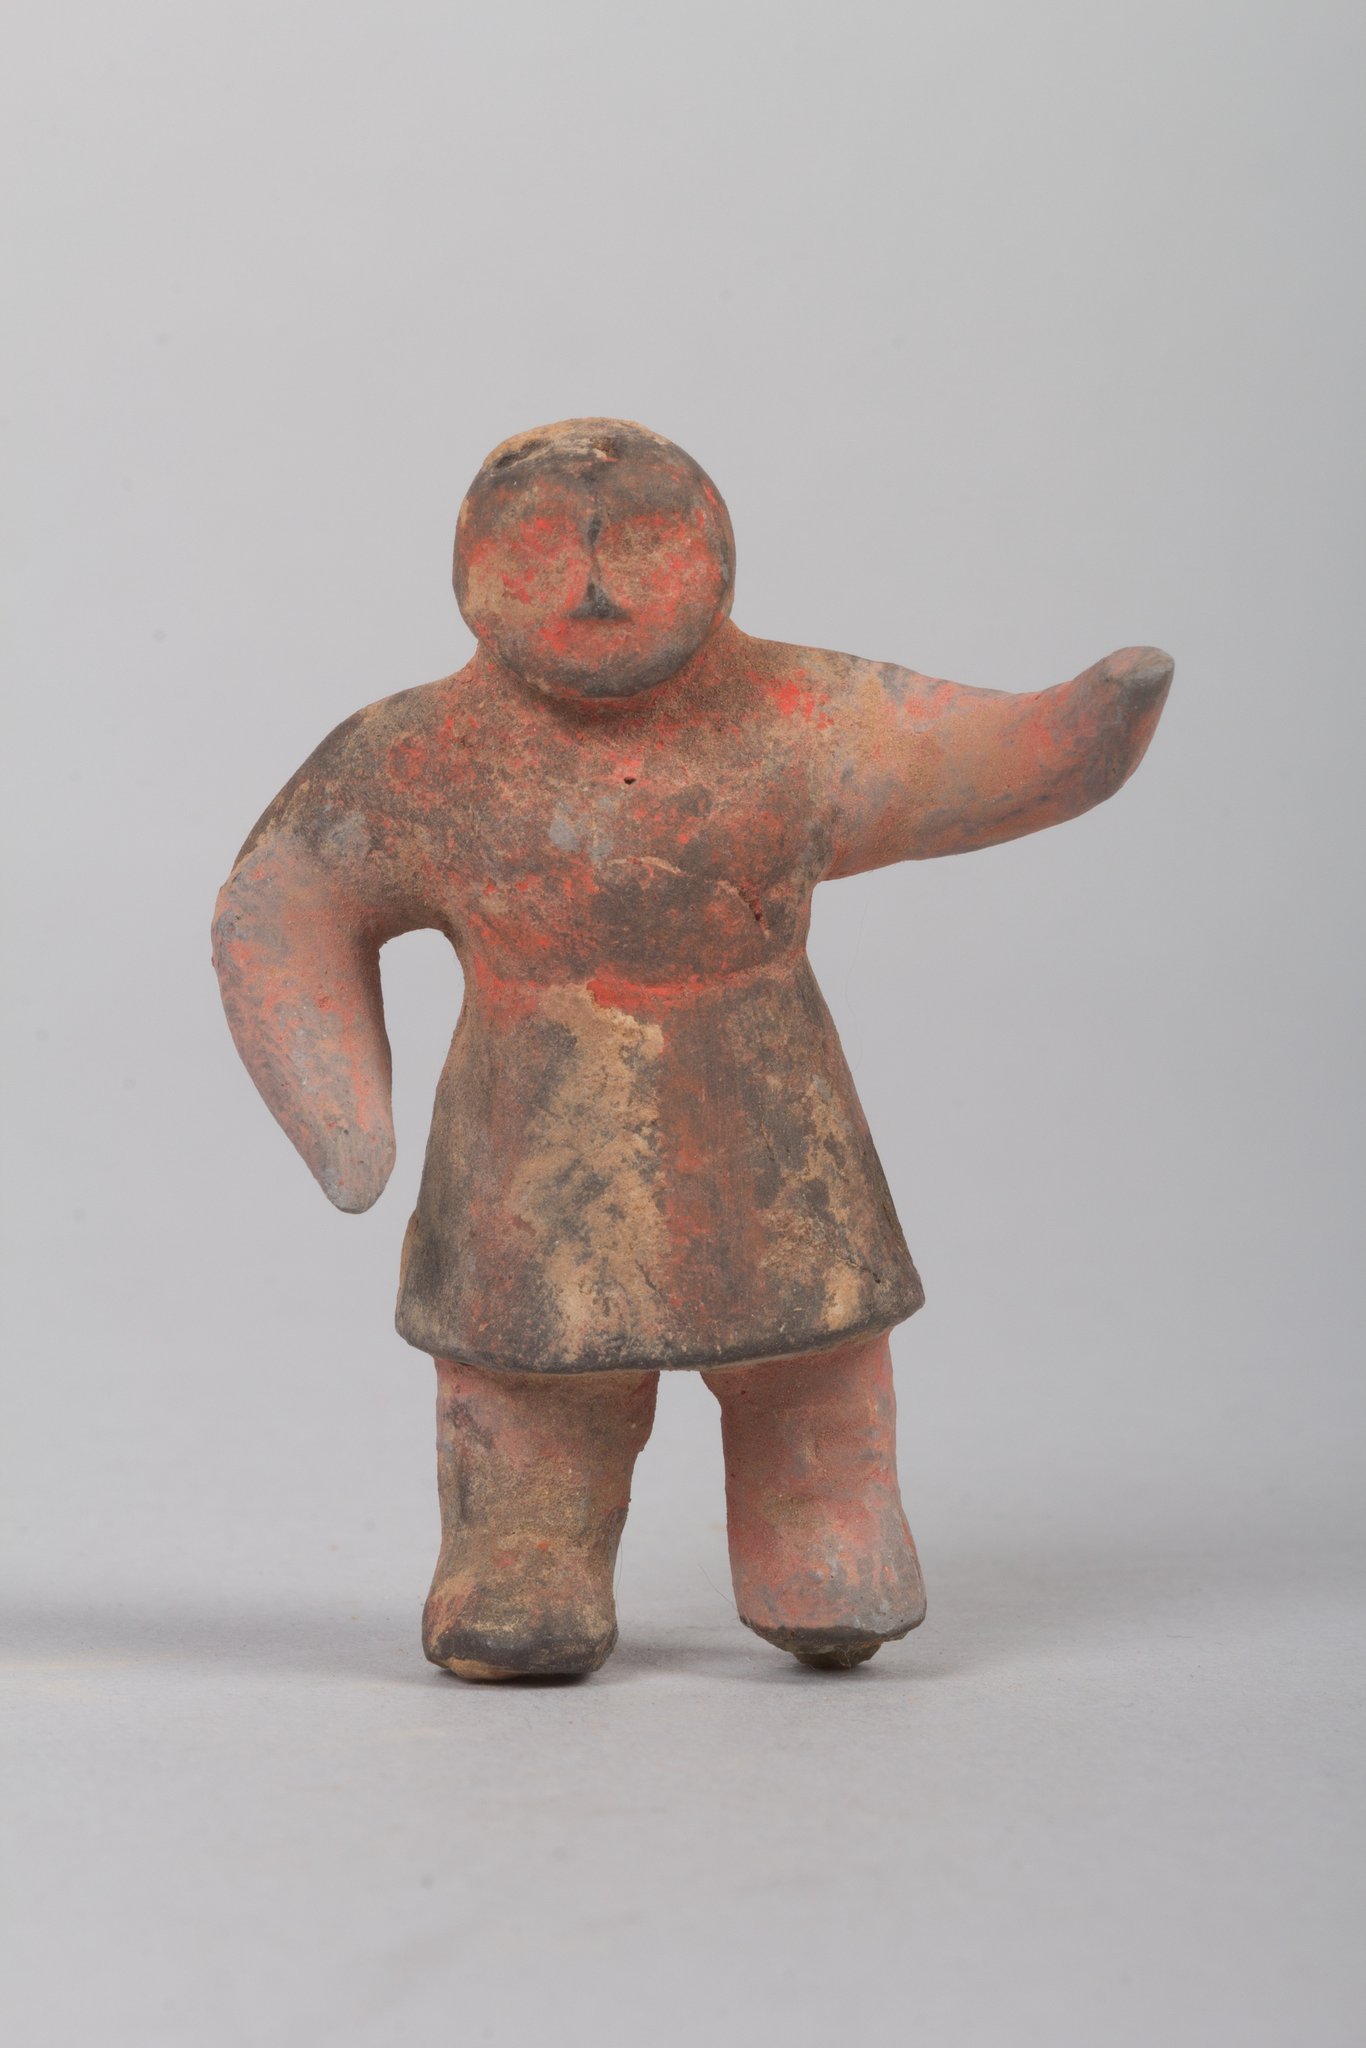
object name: figure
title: Figure of a child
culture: chinese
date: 770-256 BCE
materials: clay